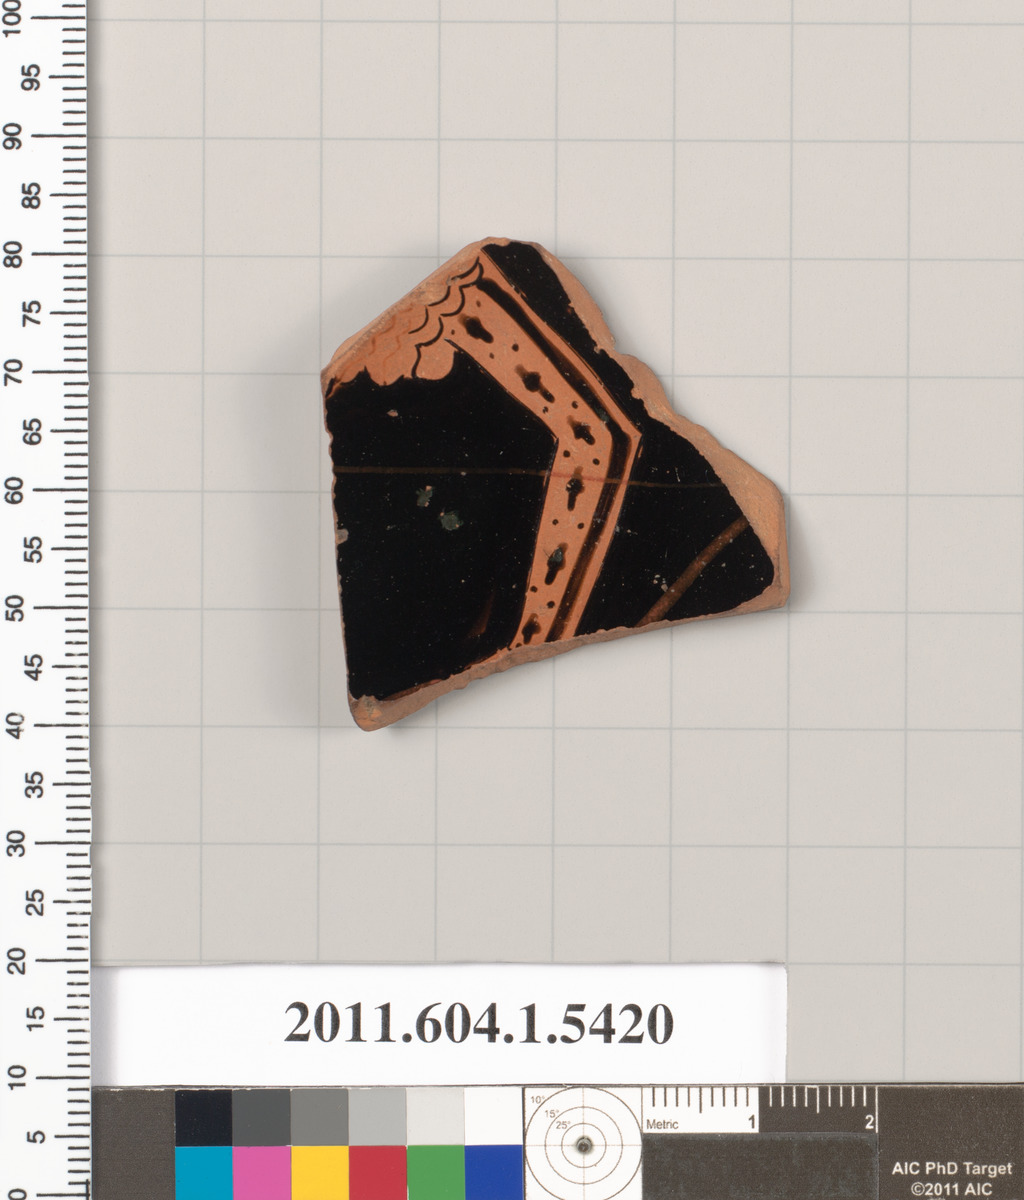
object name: kylix fragment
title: Terracotta fragment of a kylix (drinking cup)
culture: greek, attic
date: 490-480 BCE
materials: terracotta